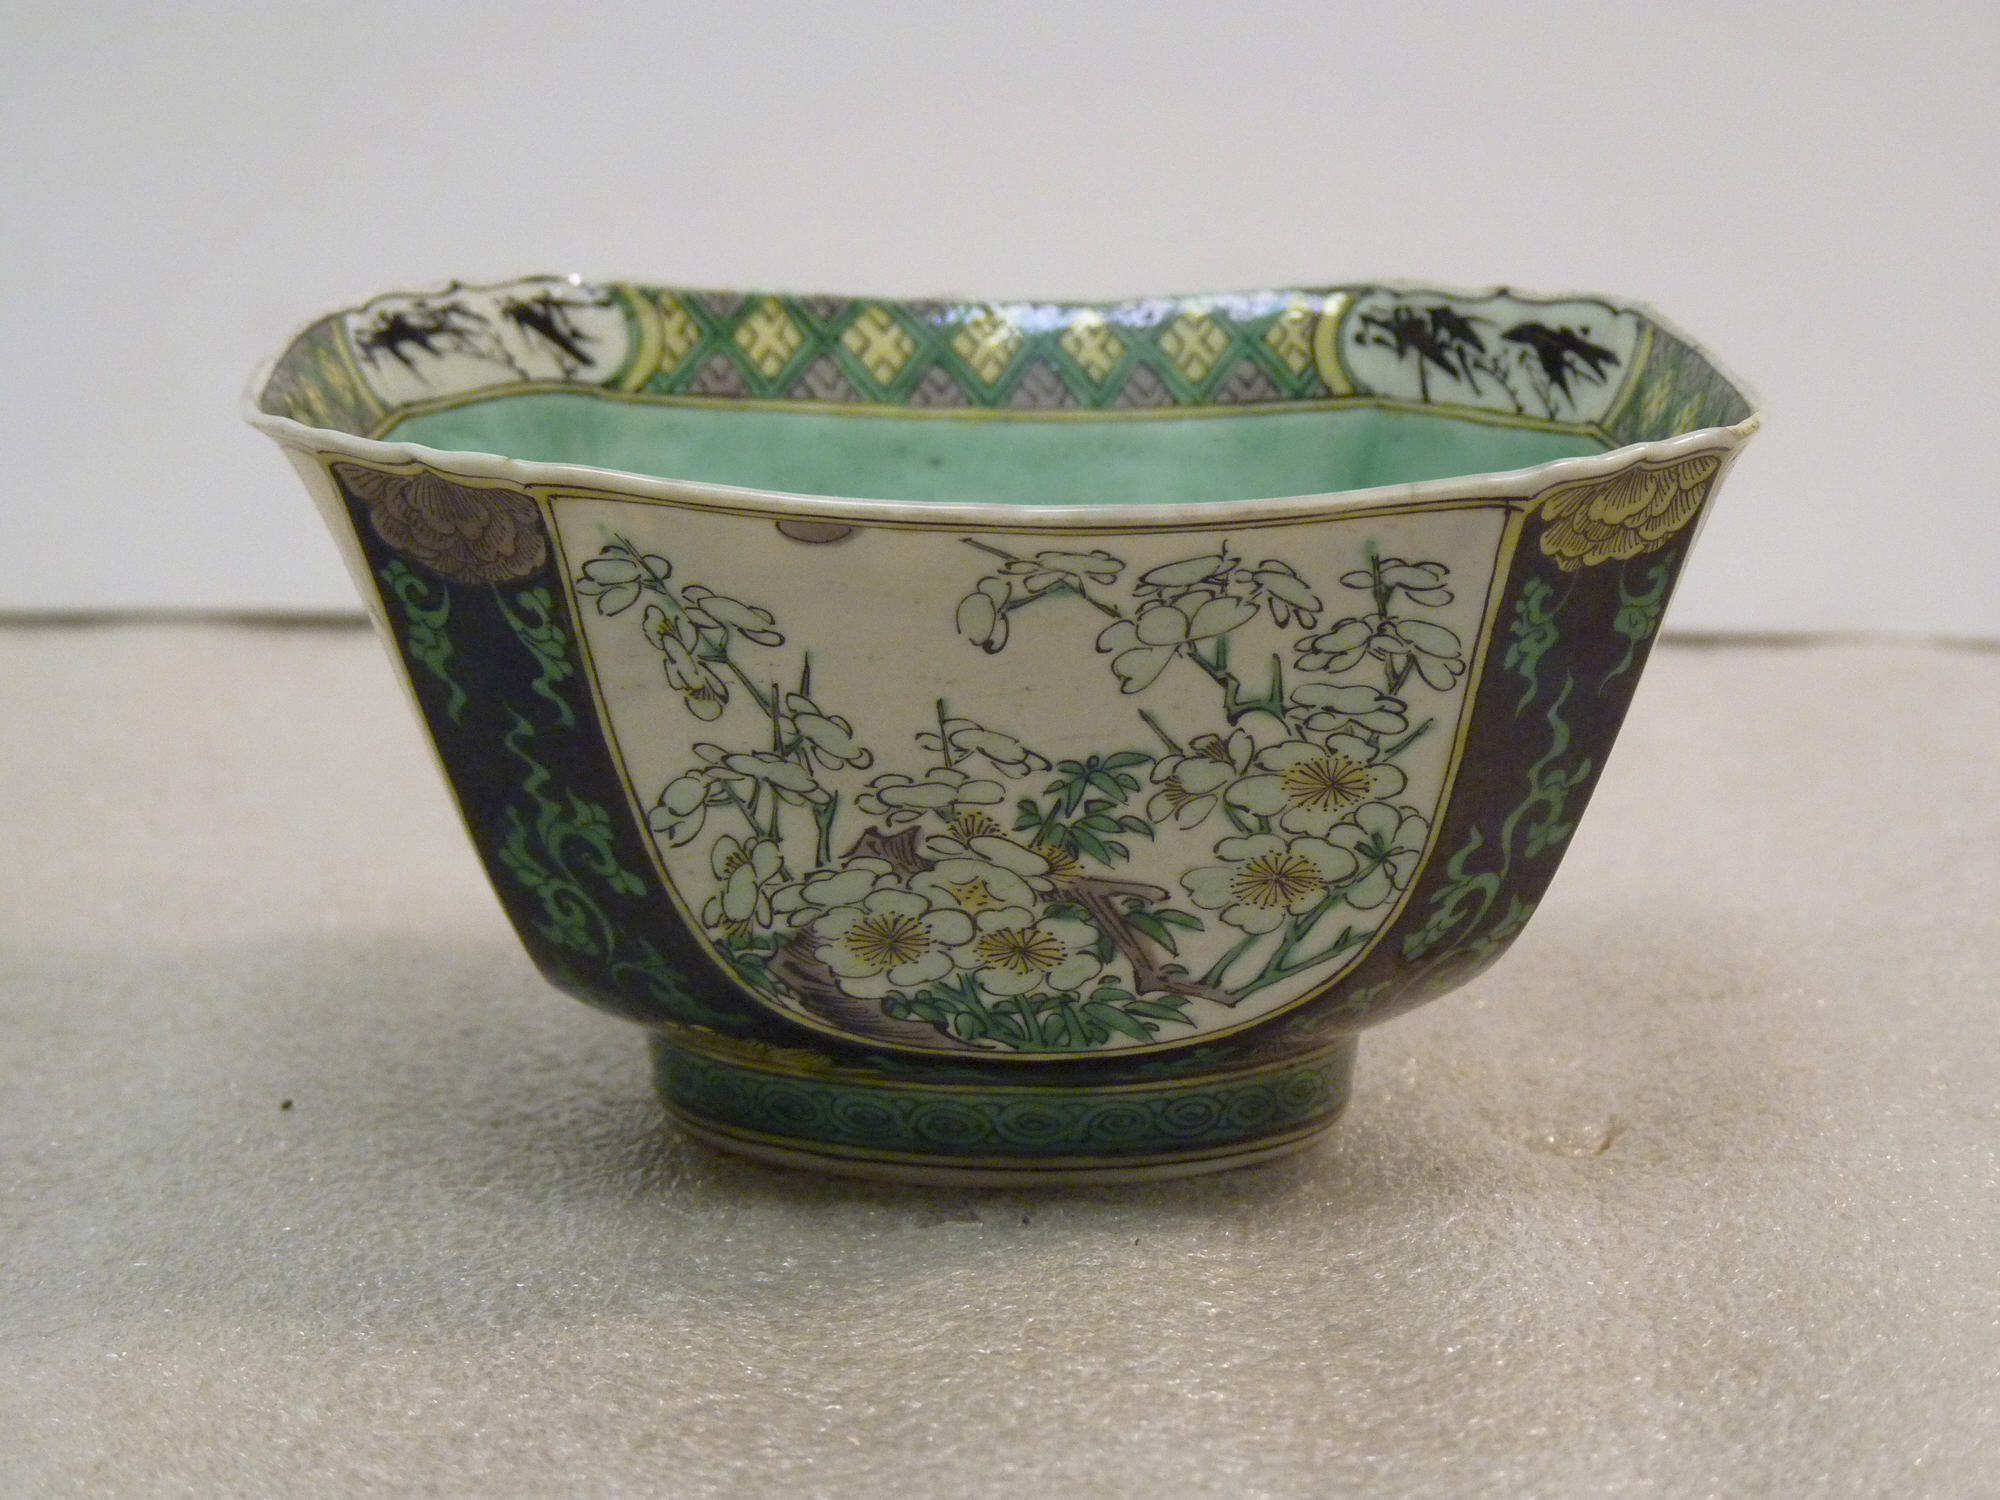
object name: bowl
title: Bowl (one of a pair)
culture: chinese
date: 1662-1722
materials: biscuit, enamel, porcelain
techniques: painting, polychrome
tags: flowers